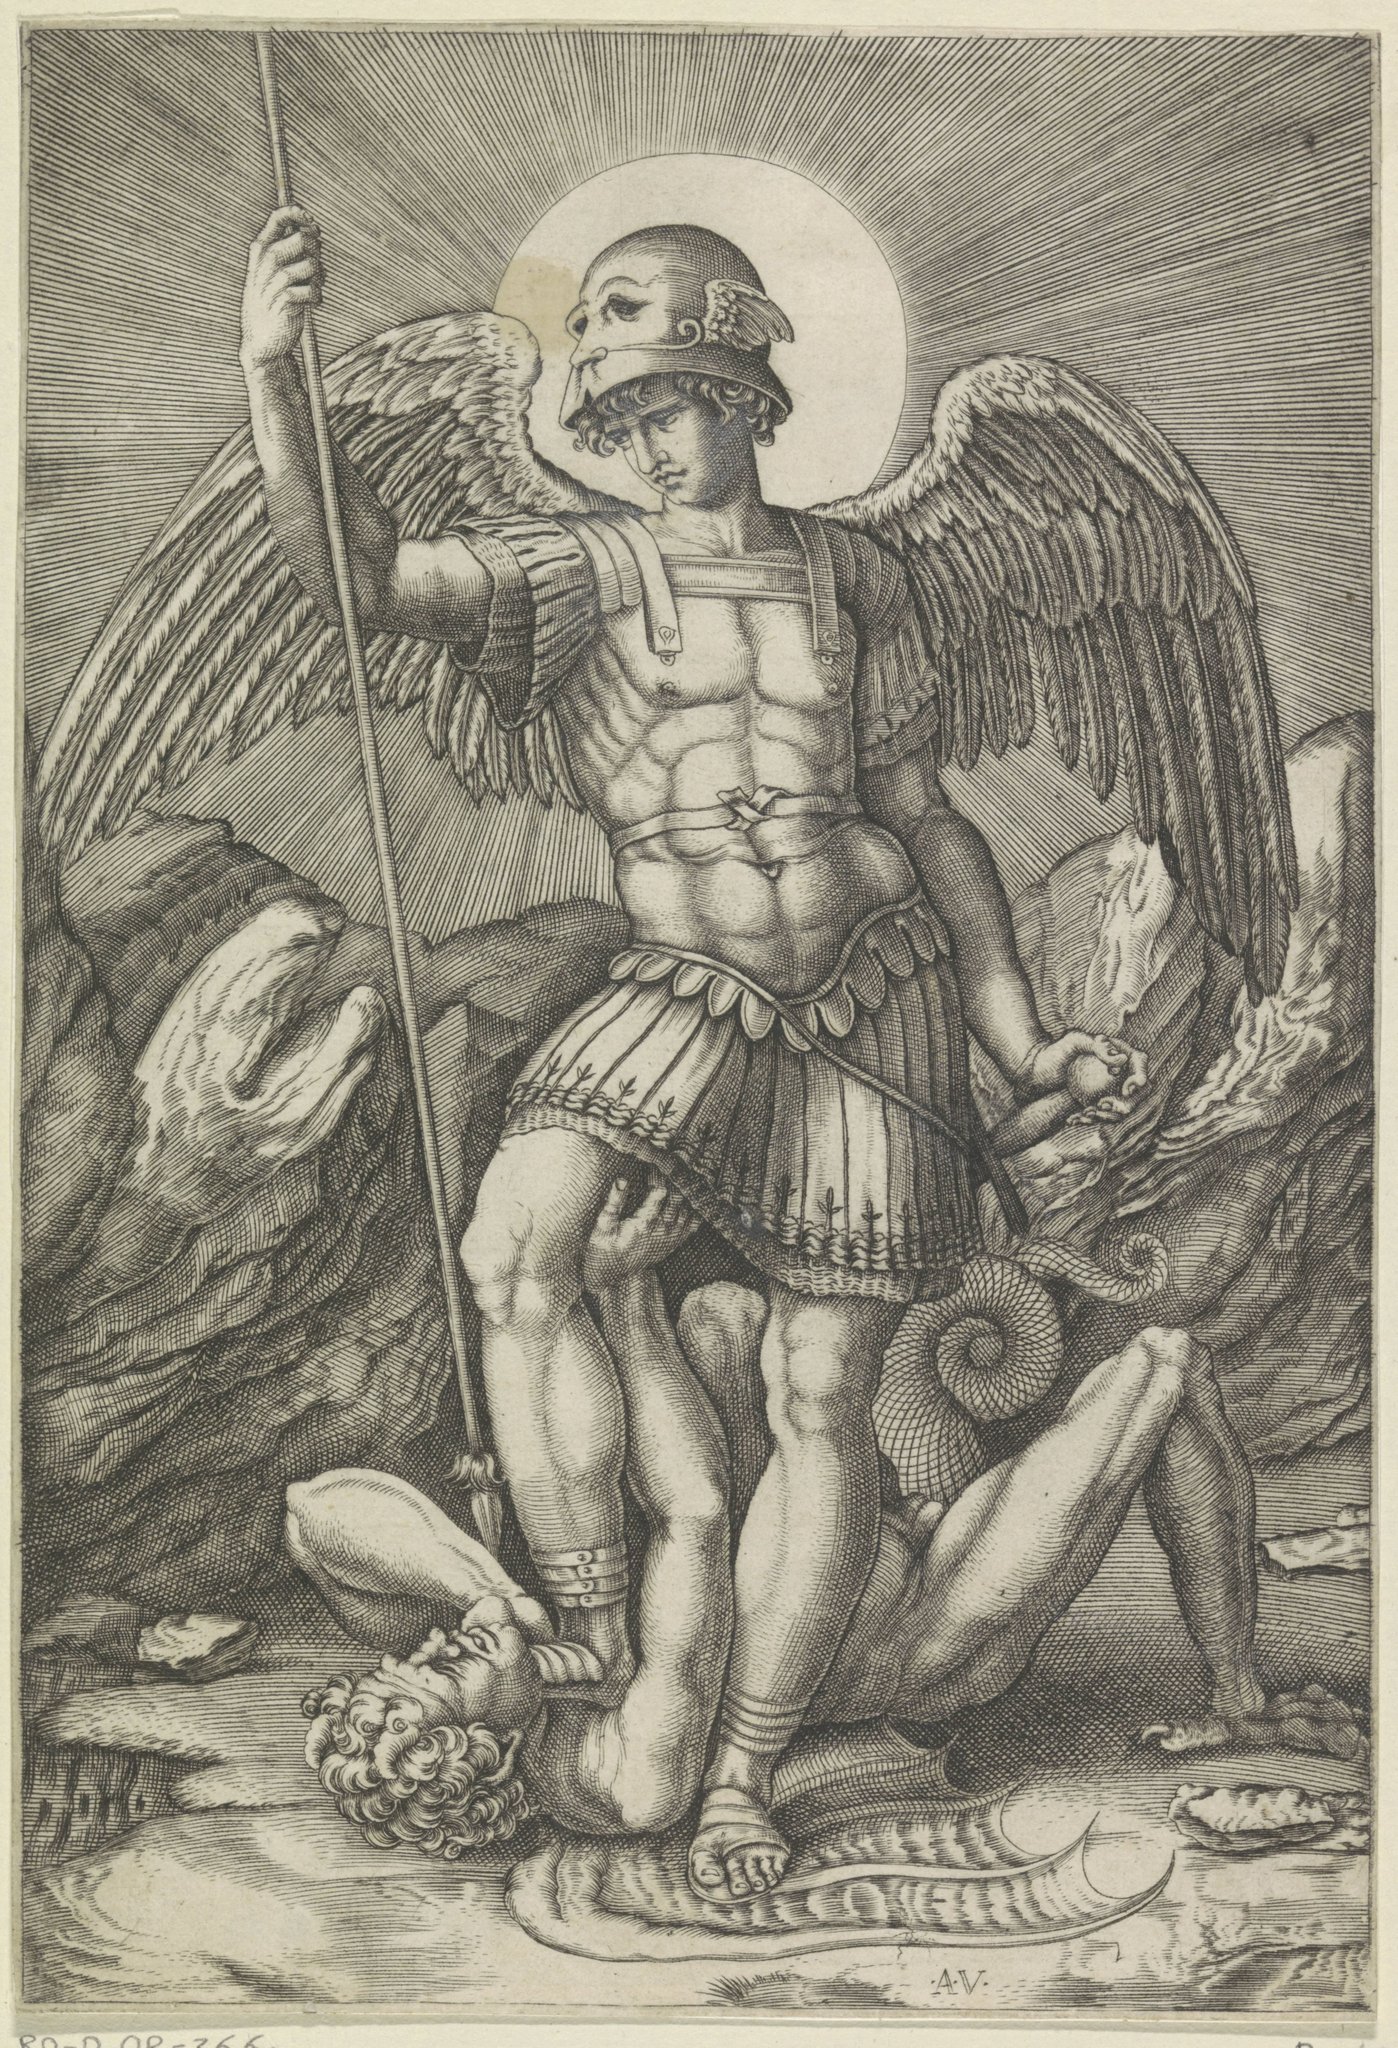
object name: print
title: Aartsengel Michaël en de draak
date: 1500-1536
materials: paper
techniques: engraving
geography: italy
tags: the archangel michael fighting the dragon (devil, satan)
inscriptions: collector's mark: Lugt 240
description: De aartsengel Michaël vertrapt de draak (de duivel). In zijn rechterhand houdt hij een lans, in zijn linkerhand een zwaard.